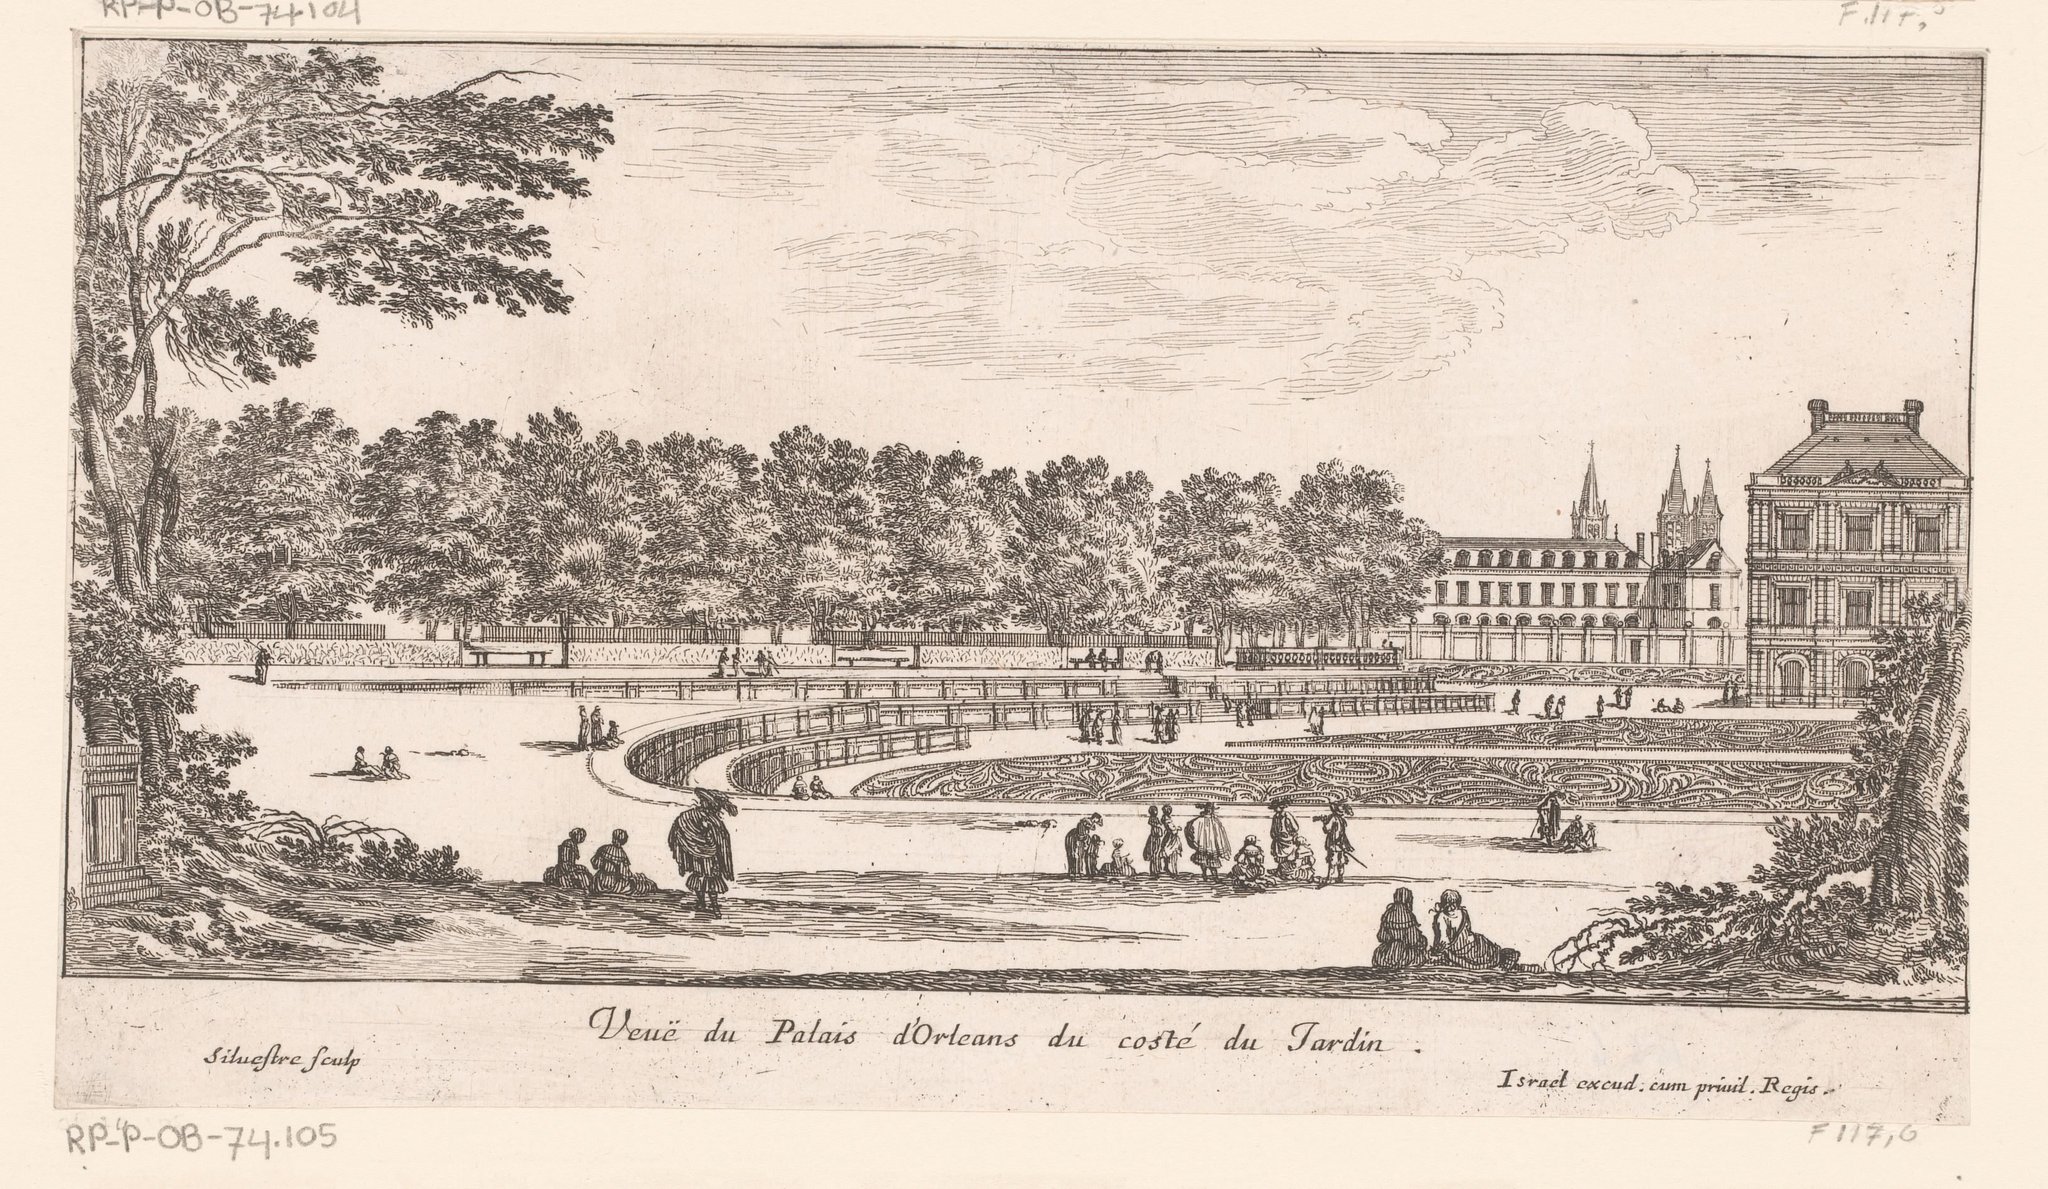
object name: print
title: Gezicht op het Palais du Luxembourg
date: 1631-1661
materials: paper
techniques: etching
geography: france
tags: palace, french or architectonic garden; formal garden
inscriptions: collector's mark: Lugt 240